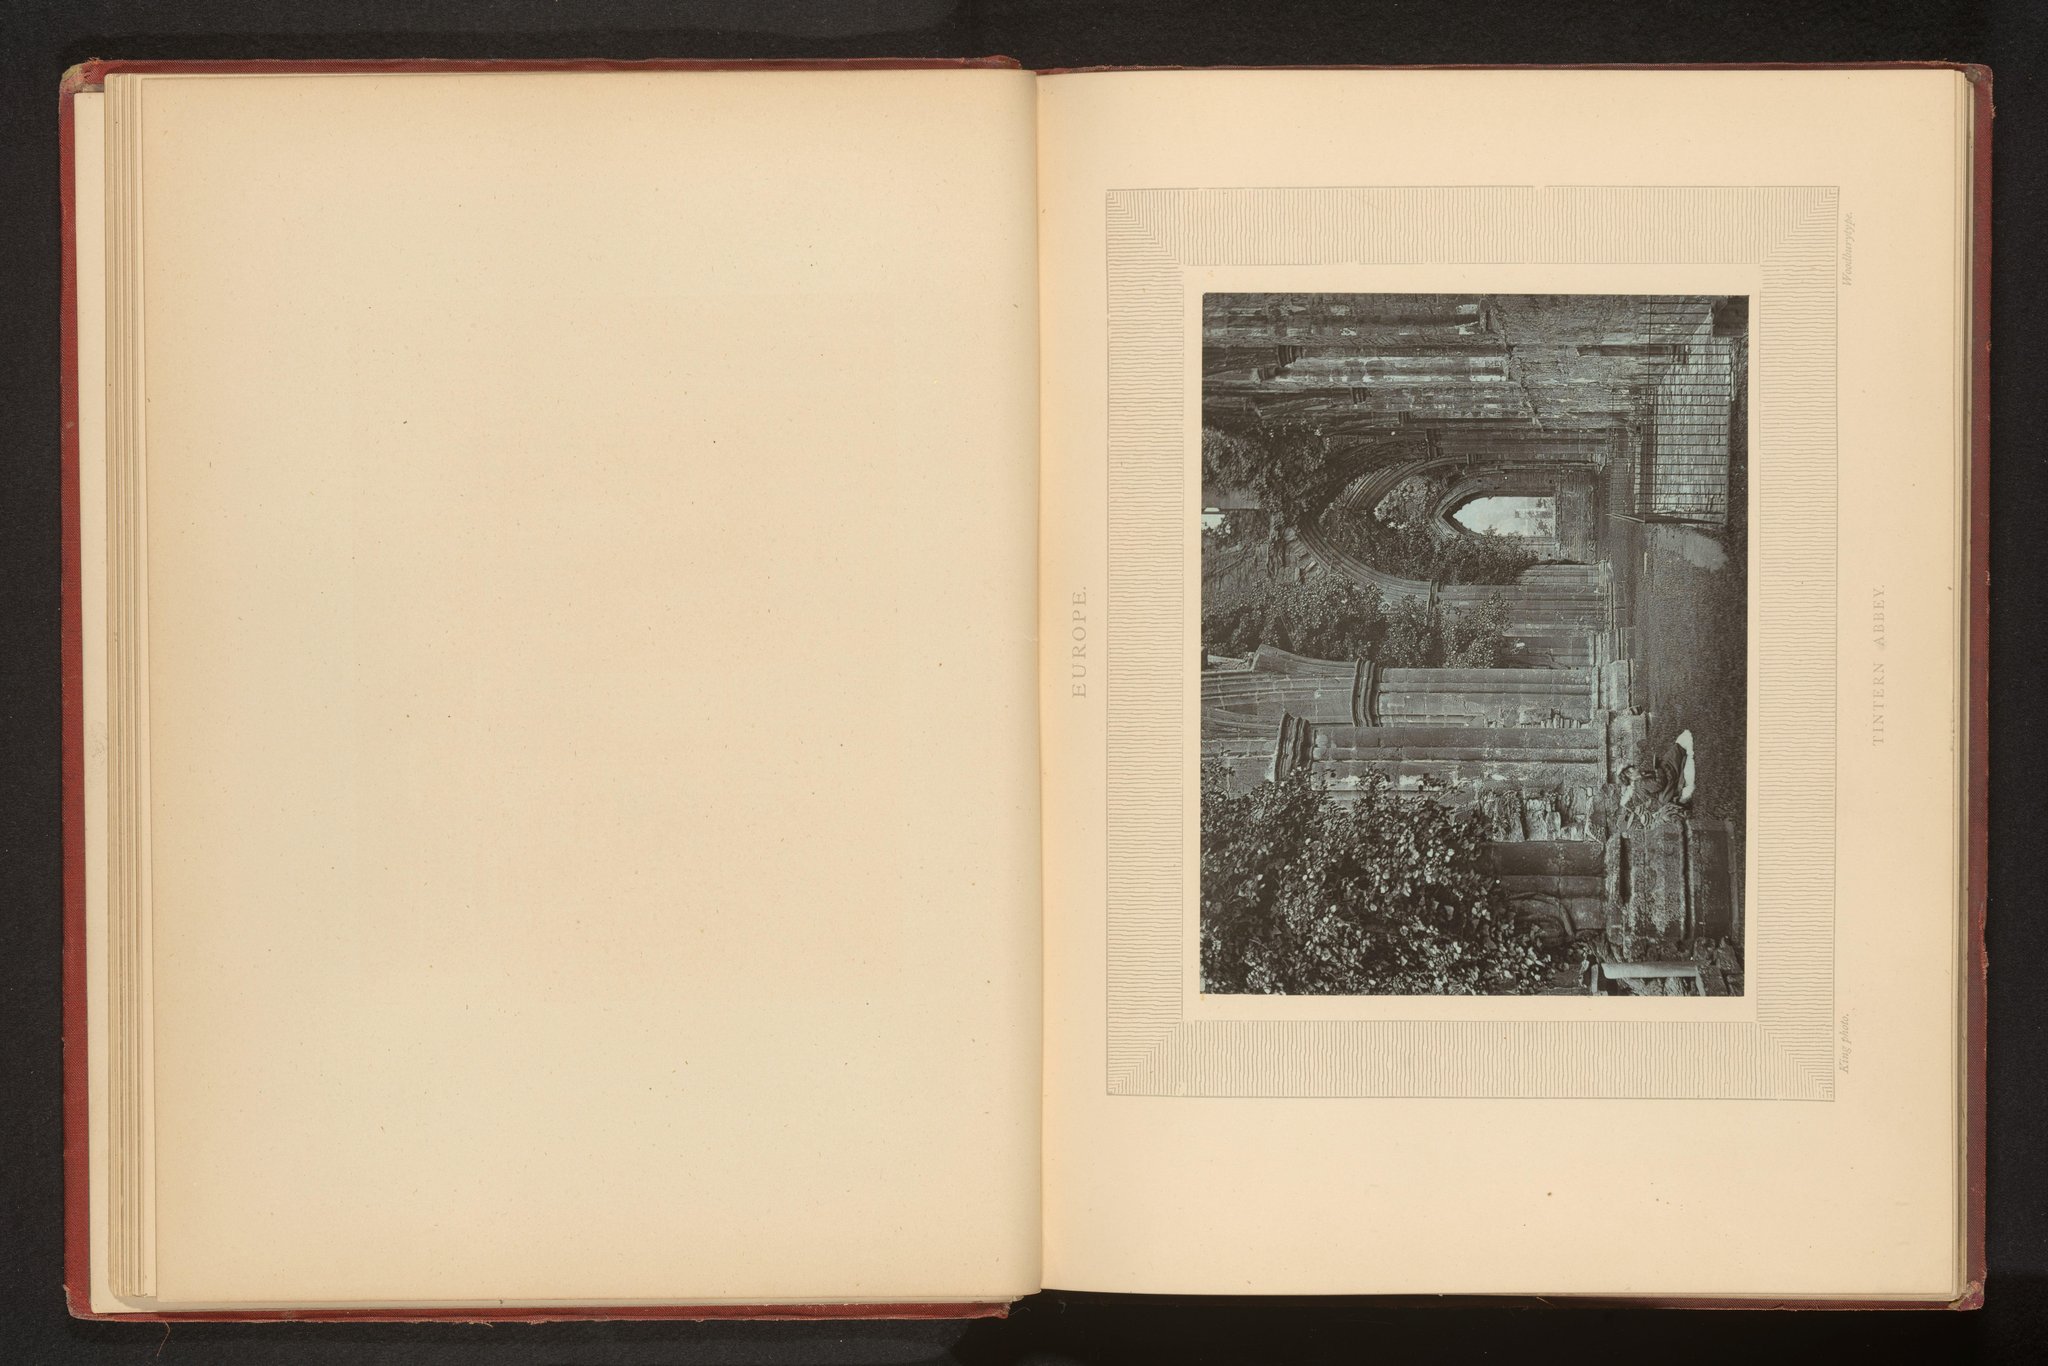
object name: photomechanical print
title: Ruïne van Tintern Abbey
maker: Anonymous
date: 1870-1875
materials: cardboard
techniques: woodburytype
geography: tintern abbey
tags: ruin of church, monastery, etc.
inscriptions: inscription: ‘King photo.’, inscription: ‘Europe’